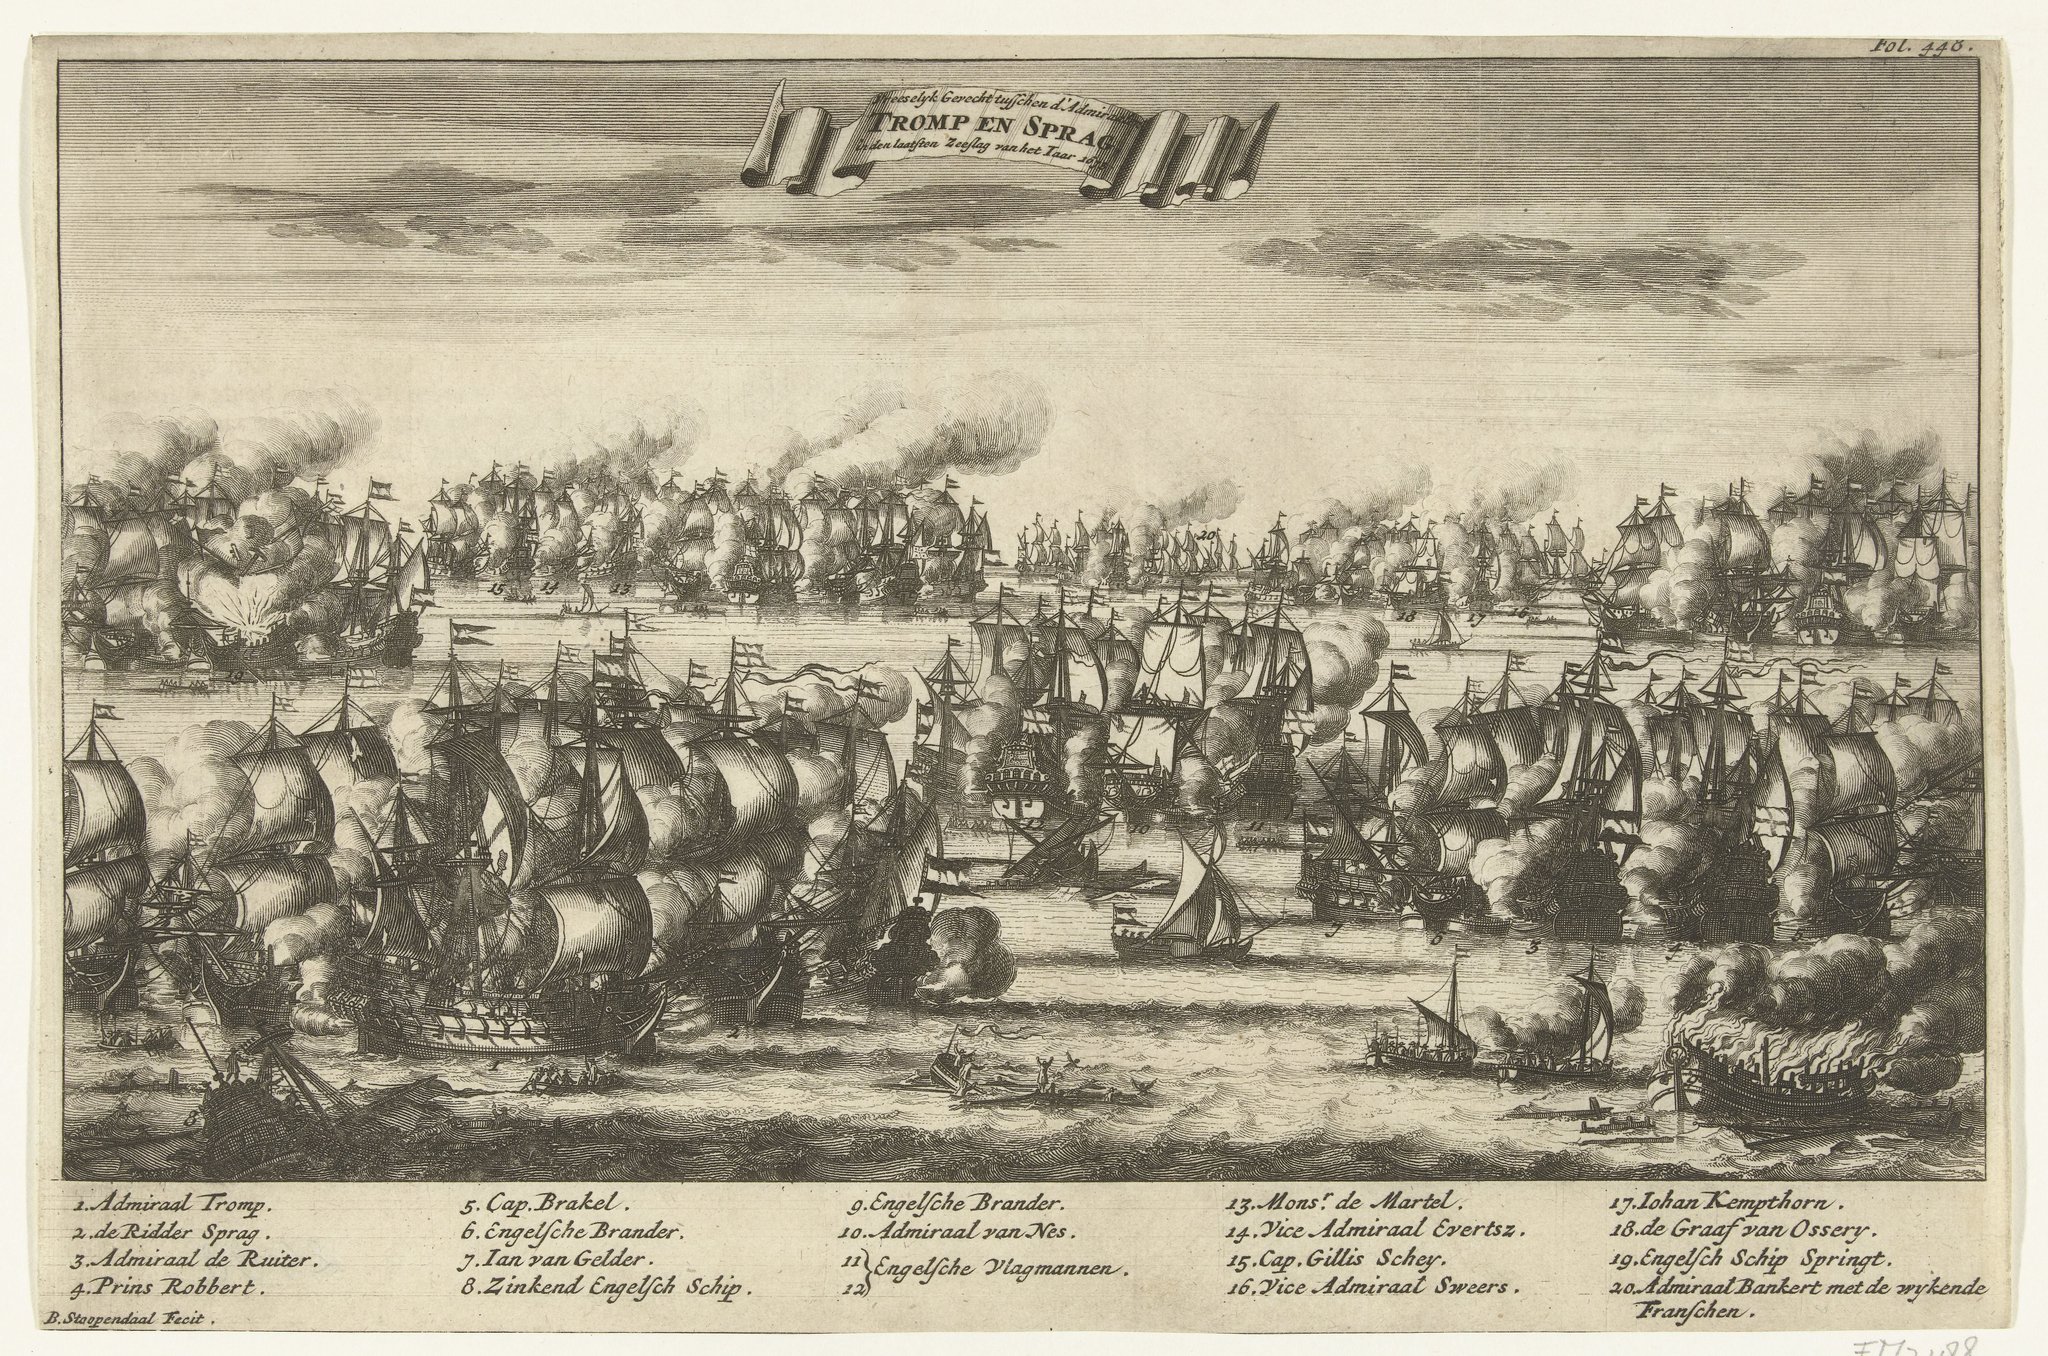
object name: history print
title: Gevecht tussen Tromp en Spragge tijdens de zeeslag bij Kijkduin, 1673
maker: bastiaen stopendael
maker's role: print maker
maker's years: 1636-1693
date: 1690-1692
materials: paper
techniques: etching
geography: northern netherlands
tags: london, print maker, draughtsman, prinz ruprecht, flushing, michiel adriaenszoon de ruyter, rotterdam, cornelis tromp, battle (+ naval force), battle of the texel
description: Gevecht tussen Cornelis Tromp en Edward Spragge tijdens de zeeslag bij Kijkduin bij Den Helder en Texel tussen de Staatse vloot onder Michiel Adriaenszoon de Ruyter en Cornelis Tromp en de gecombineerde Engels-Franse vloot onder prins Rupert en de graaf Jean d'Estrées (II). Onderaan de legenda 1-20. Gemerkt rechtsboven: Fol. 448